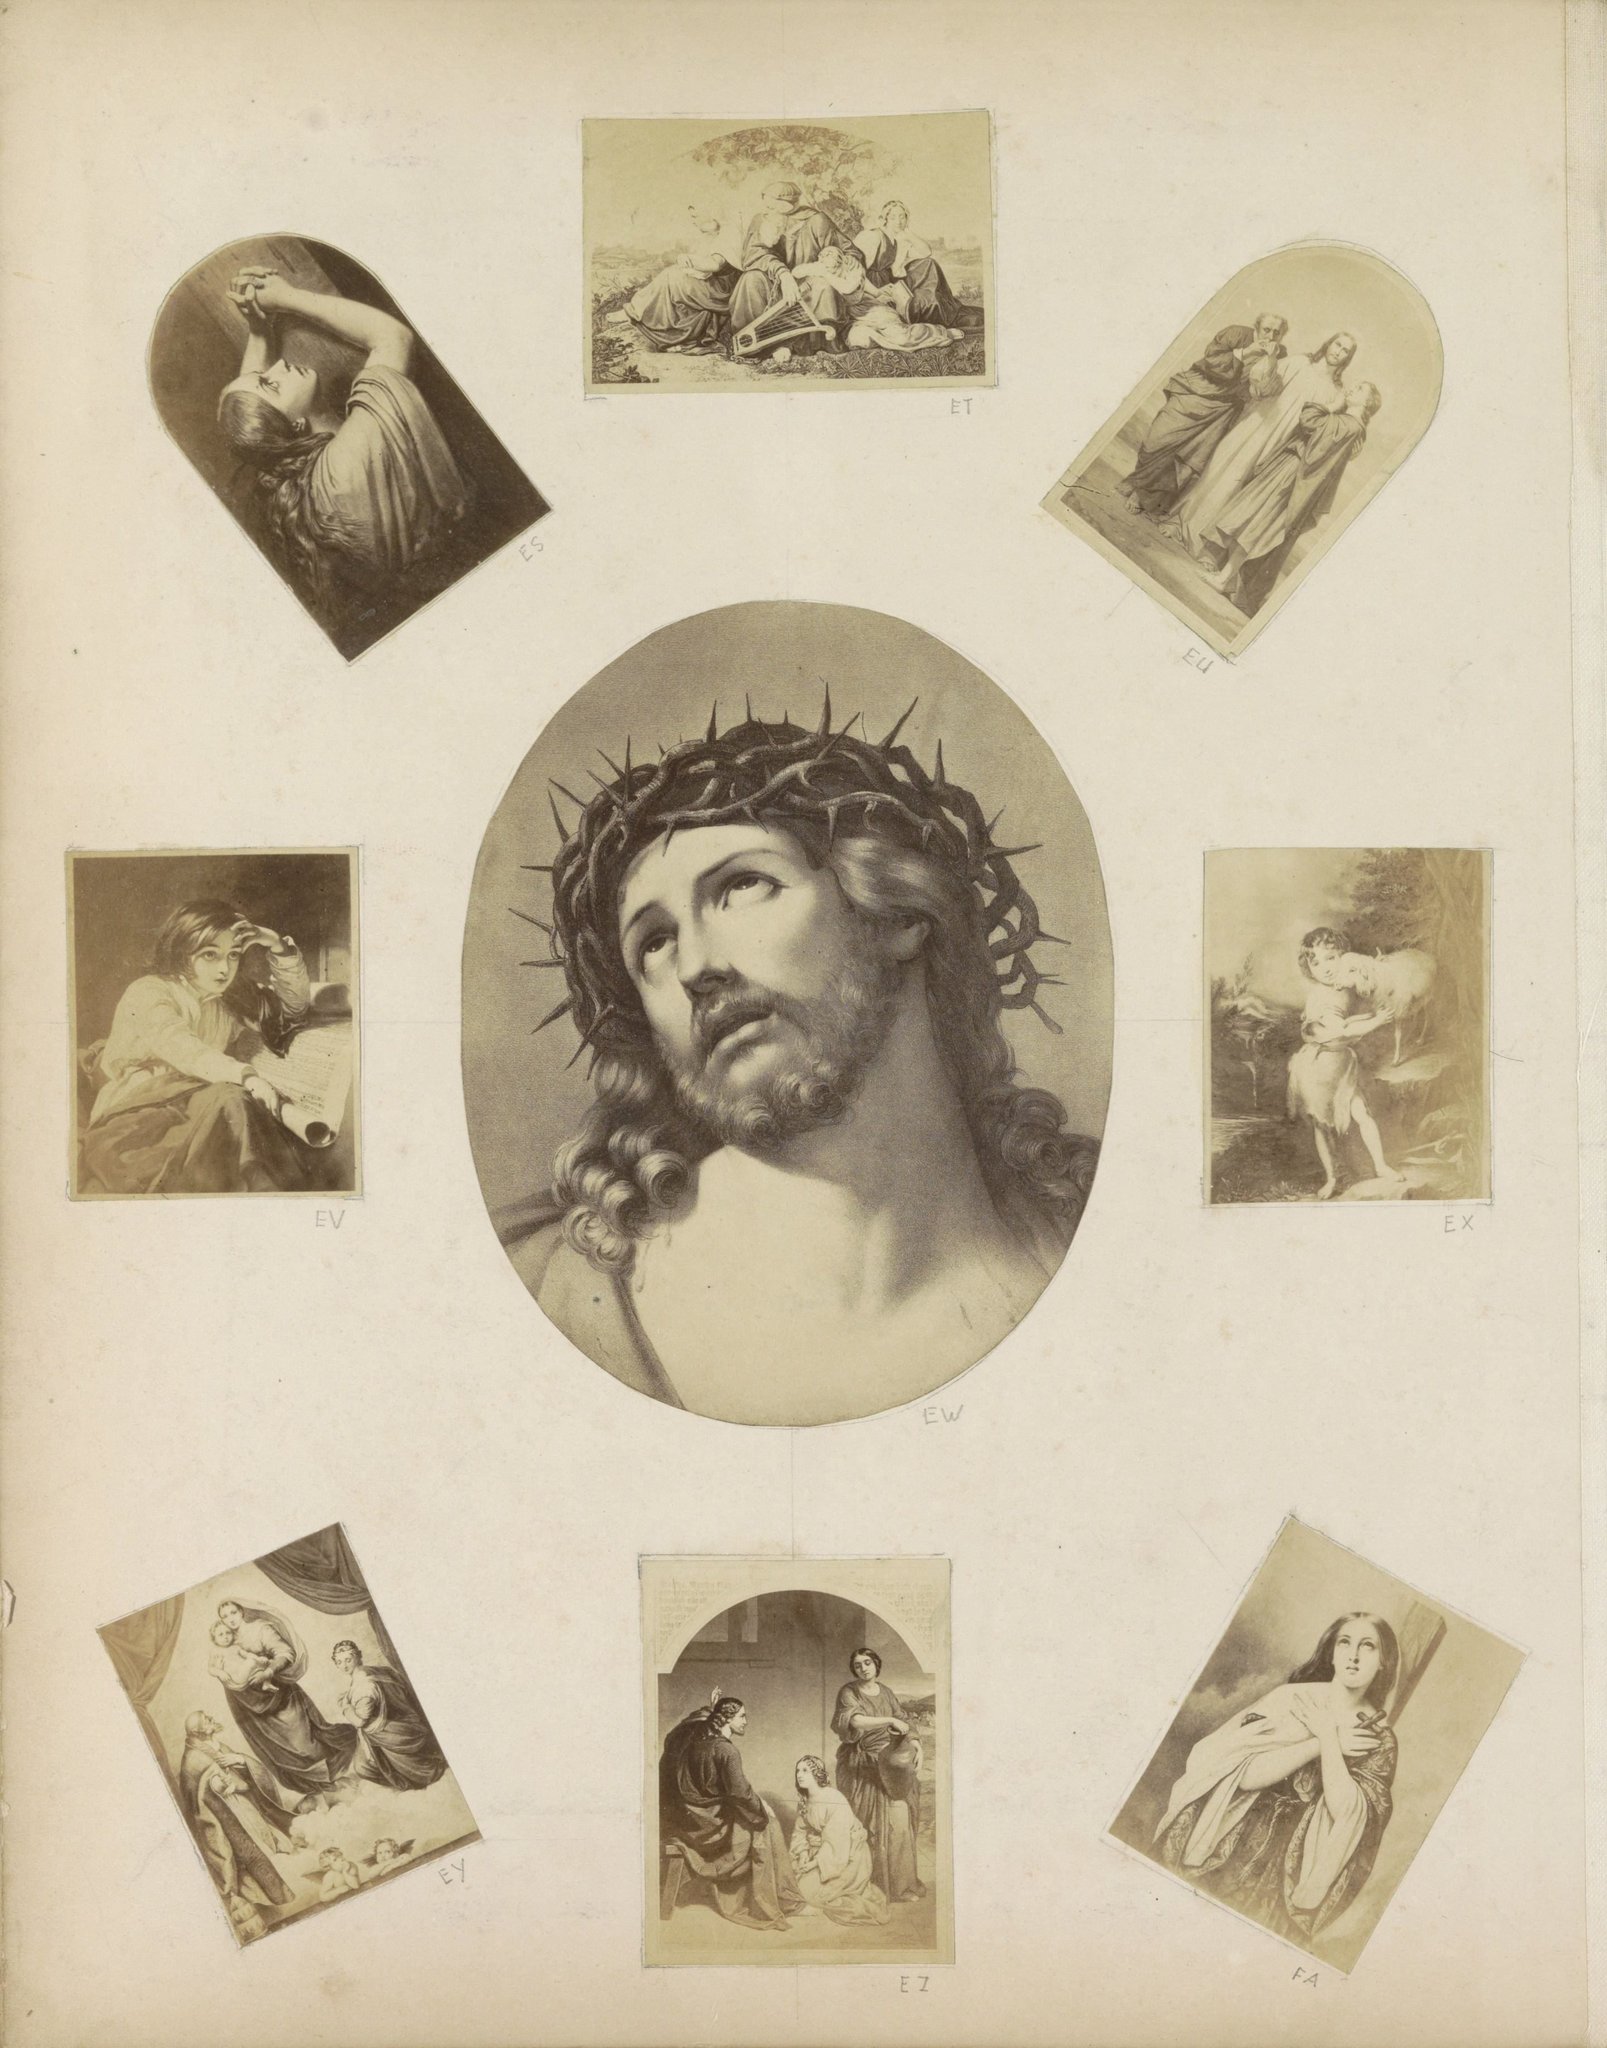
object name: reproduction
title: Fotoreproductie van (vermoedelijk) een prent voorstellend de voetwassing en -zalving door Maria Magdalena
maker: Anonymous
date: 1850-1870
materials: paper, photographic support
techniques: albumen print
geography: england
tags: christ's feet are anointed by mary (magdalene)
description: Onderdeel van Album met foto's van bezienswaardigheden en landschappen in Engeland en van kunst.